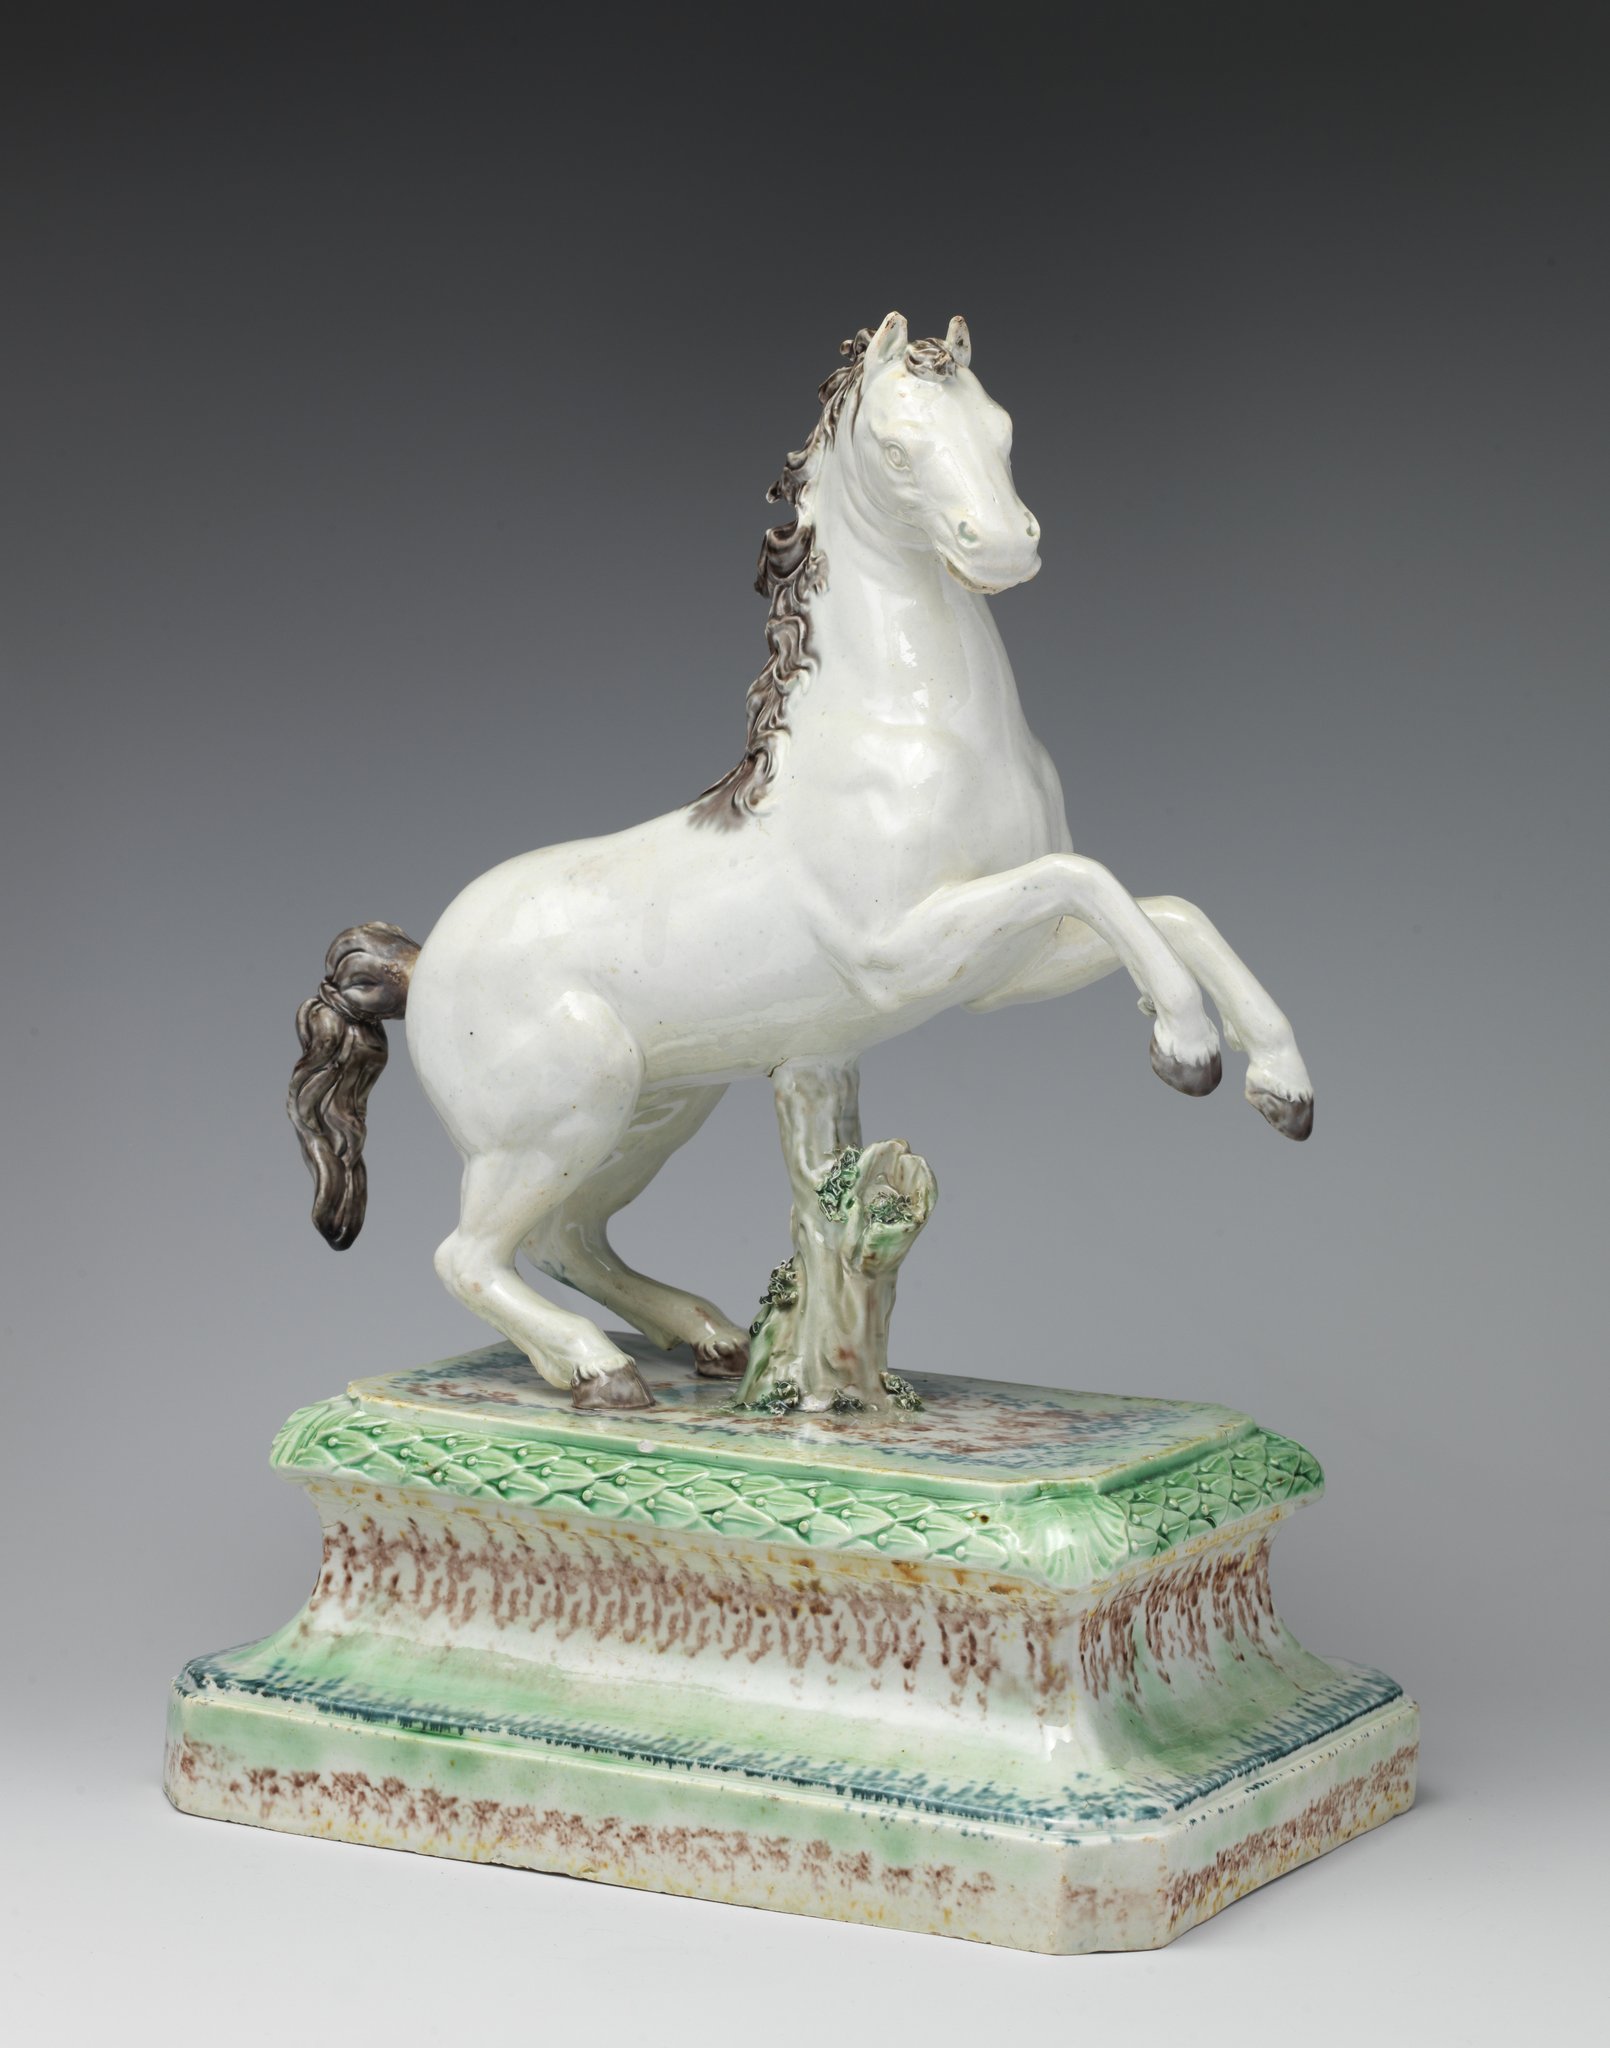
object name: figure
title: Prancing horse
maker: ralph wood the younger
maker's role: maker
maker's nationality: british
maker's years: 1748-1795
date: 1780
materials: earthenware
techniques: glazing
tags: horses